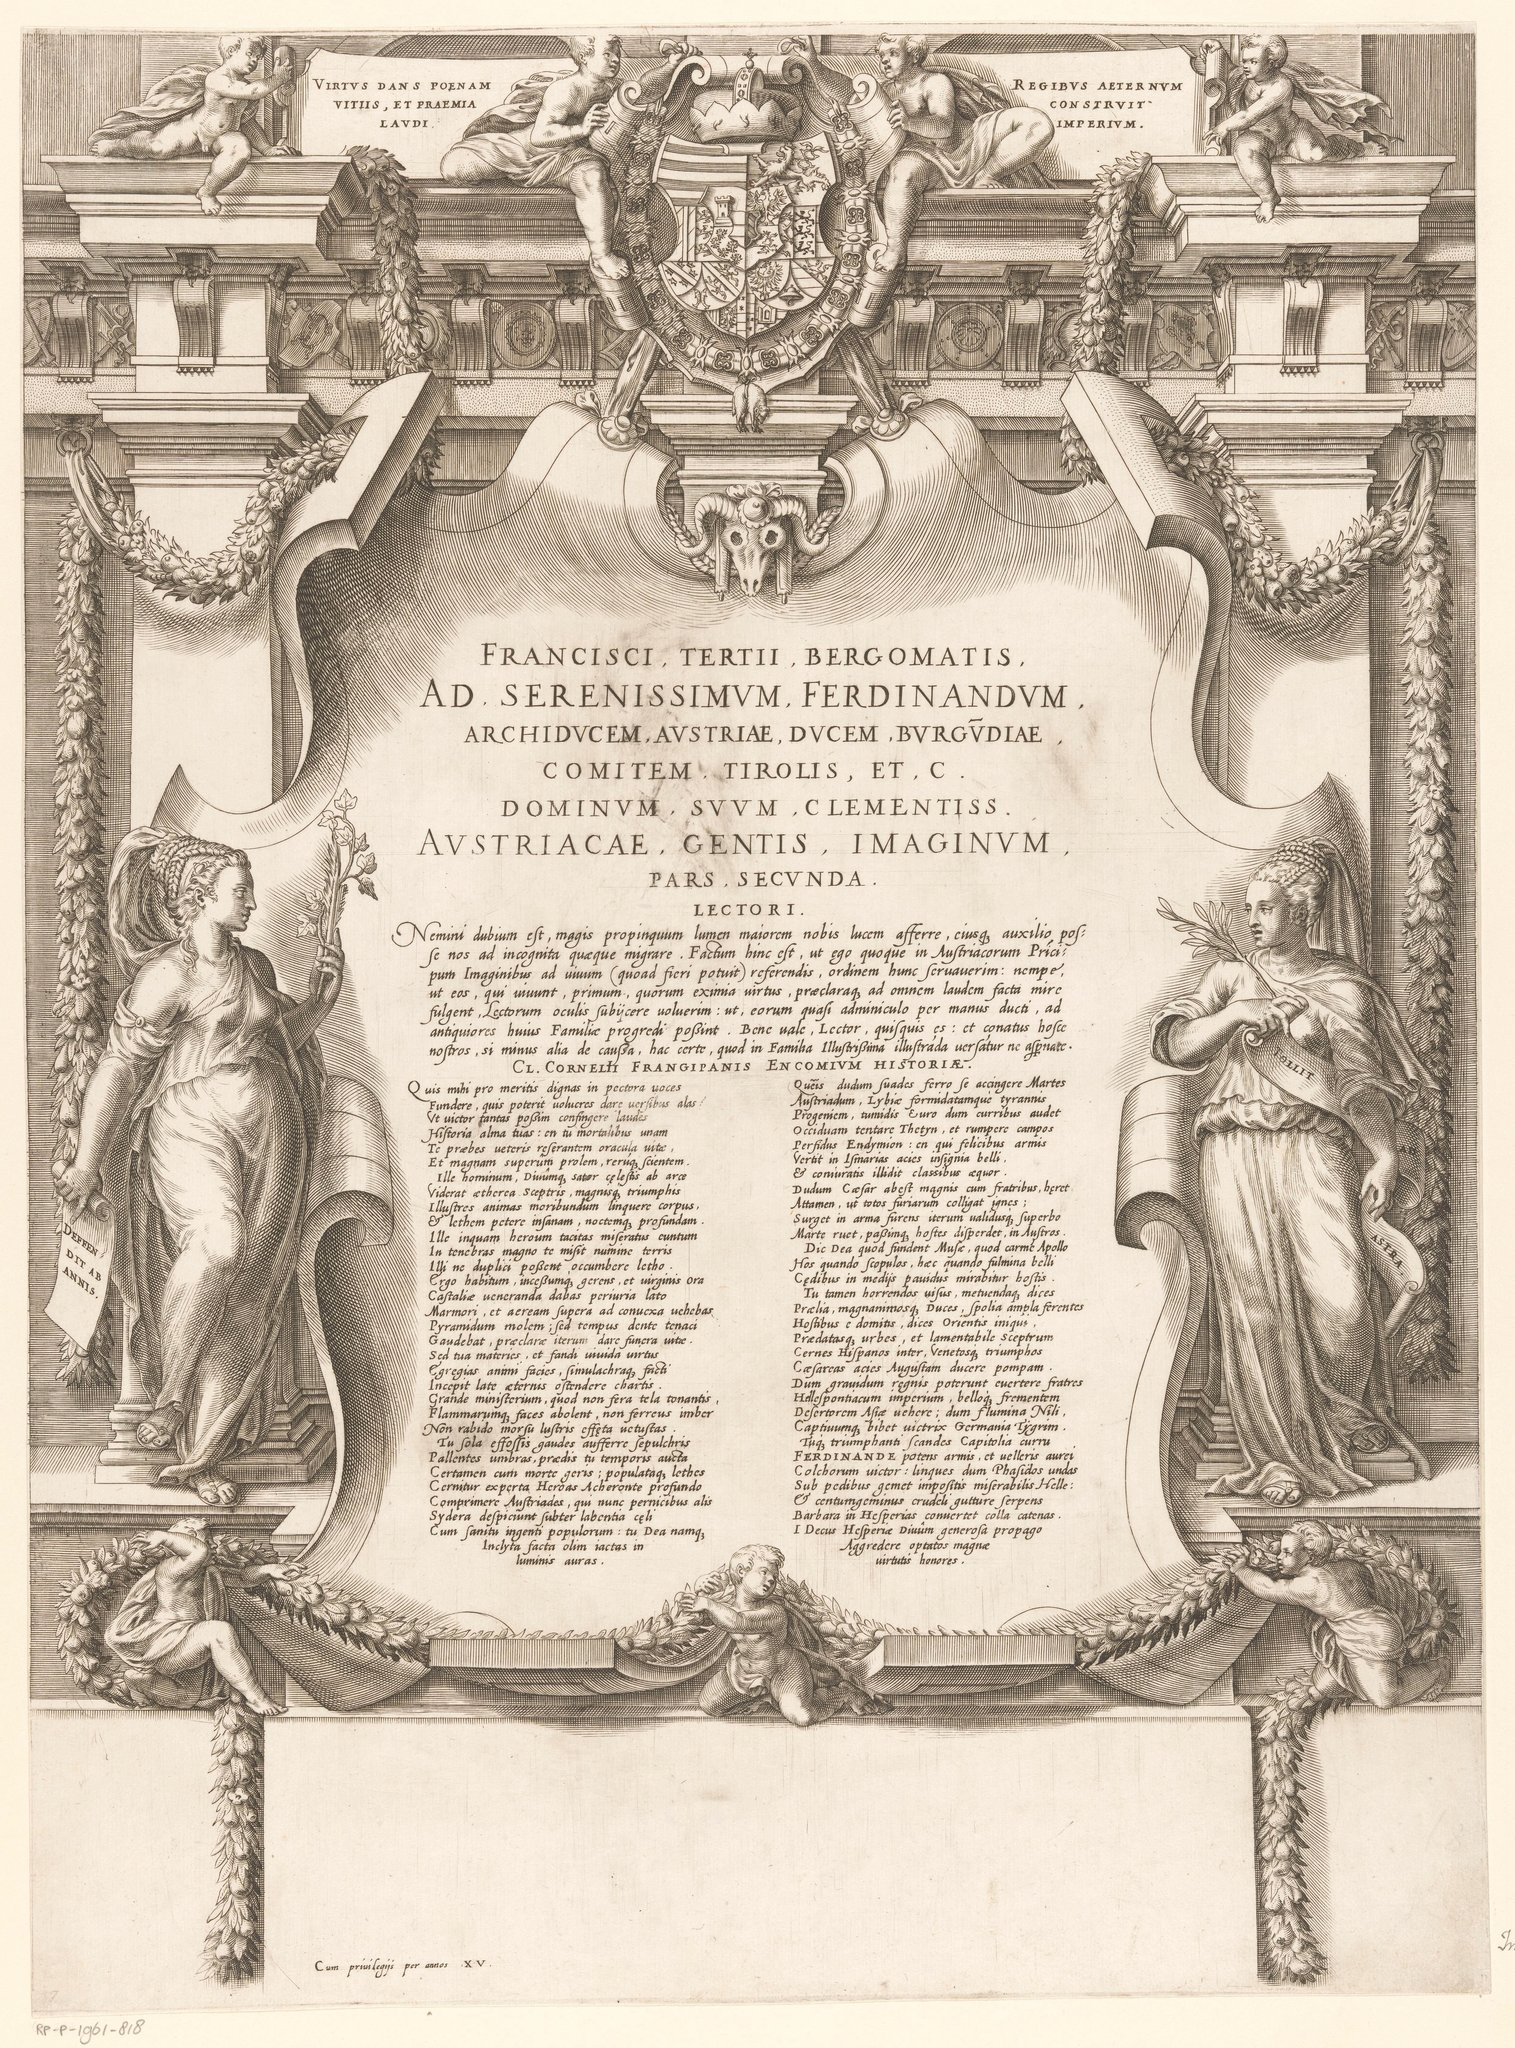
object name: titelprent, frontispice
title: Portretten van leden van het Oostenrijkse Huis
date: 1569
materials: paper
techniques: engraving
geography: italy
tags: coat of arms (symbol of sovereignty), ornaments ~ art, cupids: 'amores', 'amoretti', 'putti'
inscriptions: collector's mark: Lugt 2228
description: Deze prent maakt deel uit van een reeks van 58 prenten. Het meerendeel van de prenten bevat portretten van 74 leden van het Oostenrijkse Huis, naar tekeningen door Francesco Terzio, die deels getekend zijn naar de 28 levensgrote bronzen beelden die rond de cenotaaf van Maximiliaan I in de Hofkirche te Innsbruck staan.